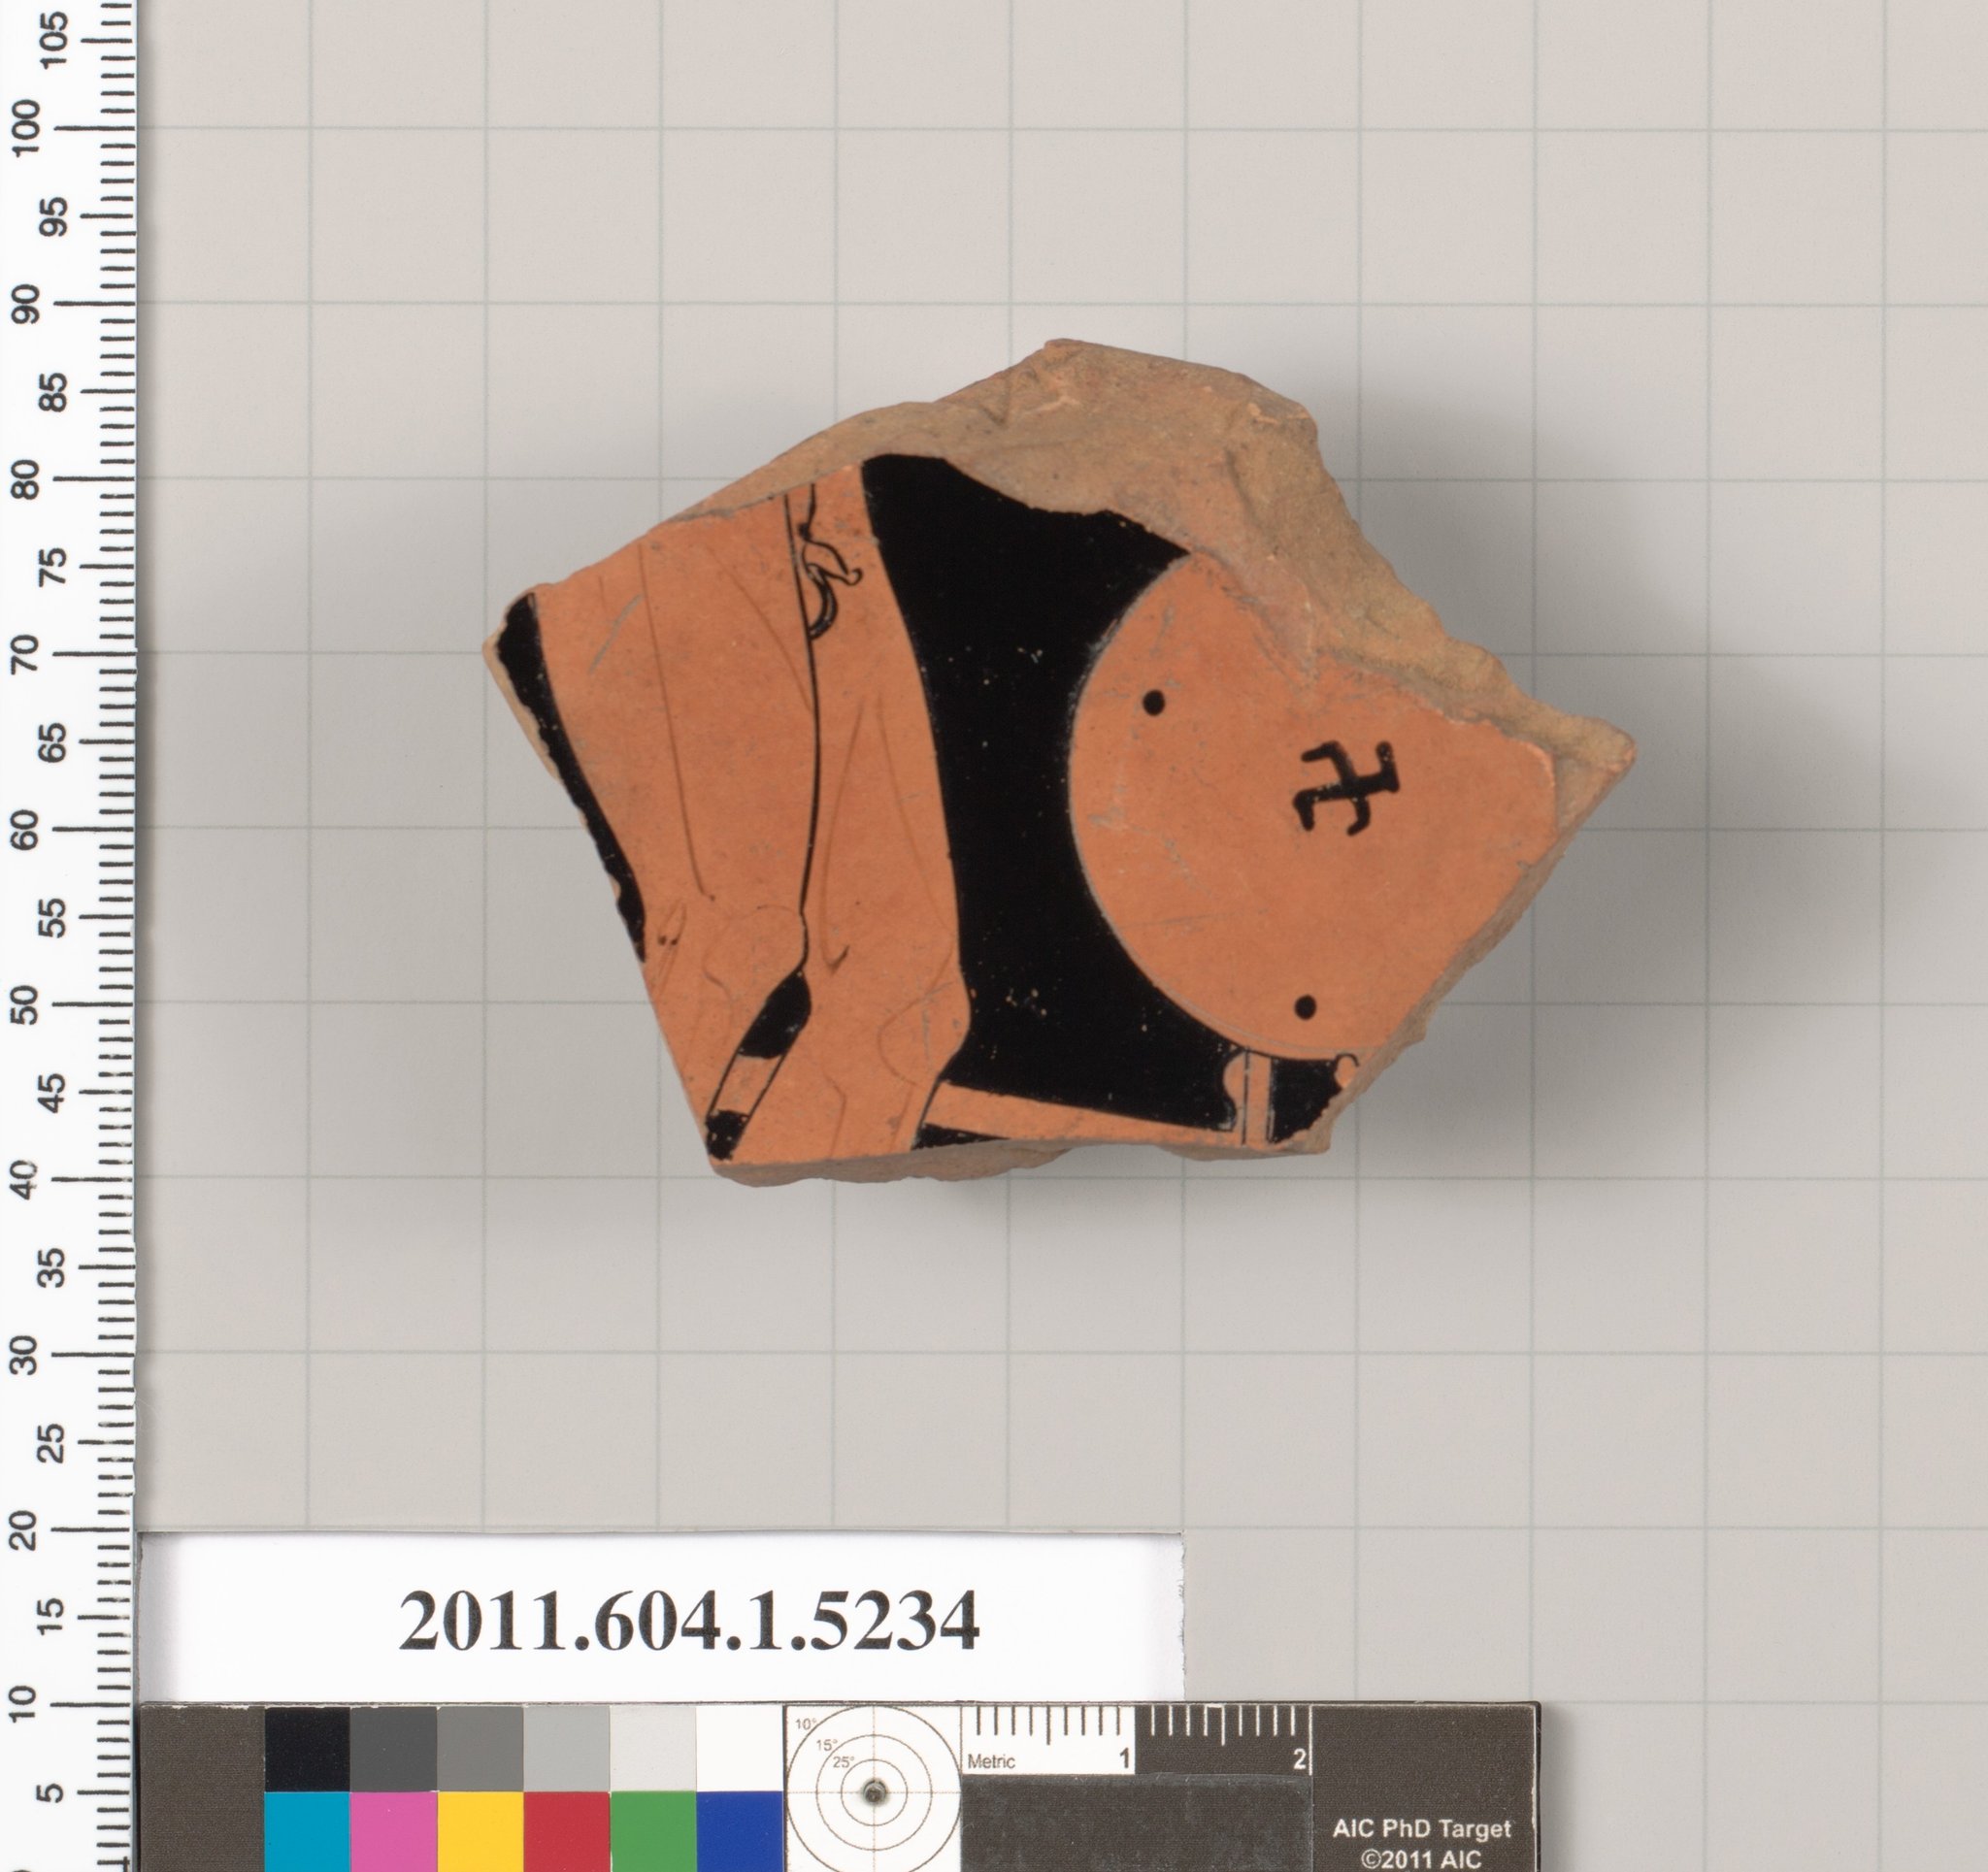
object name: kylix fragment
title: Terracotta fragment of a kylix (drinking cup)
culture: greek, attic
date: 520-500 BCE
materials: terracotta